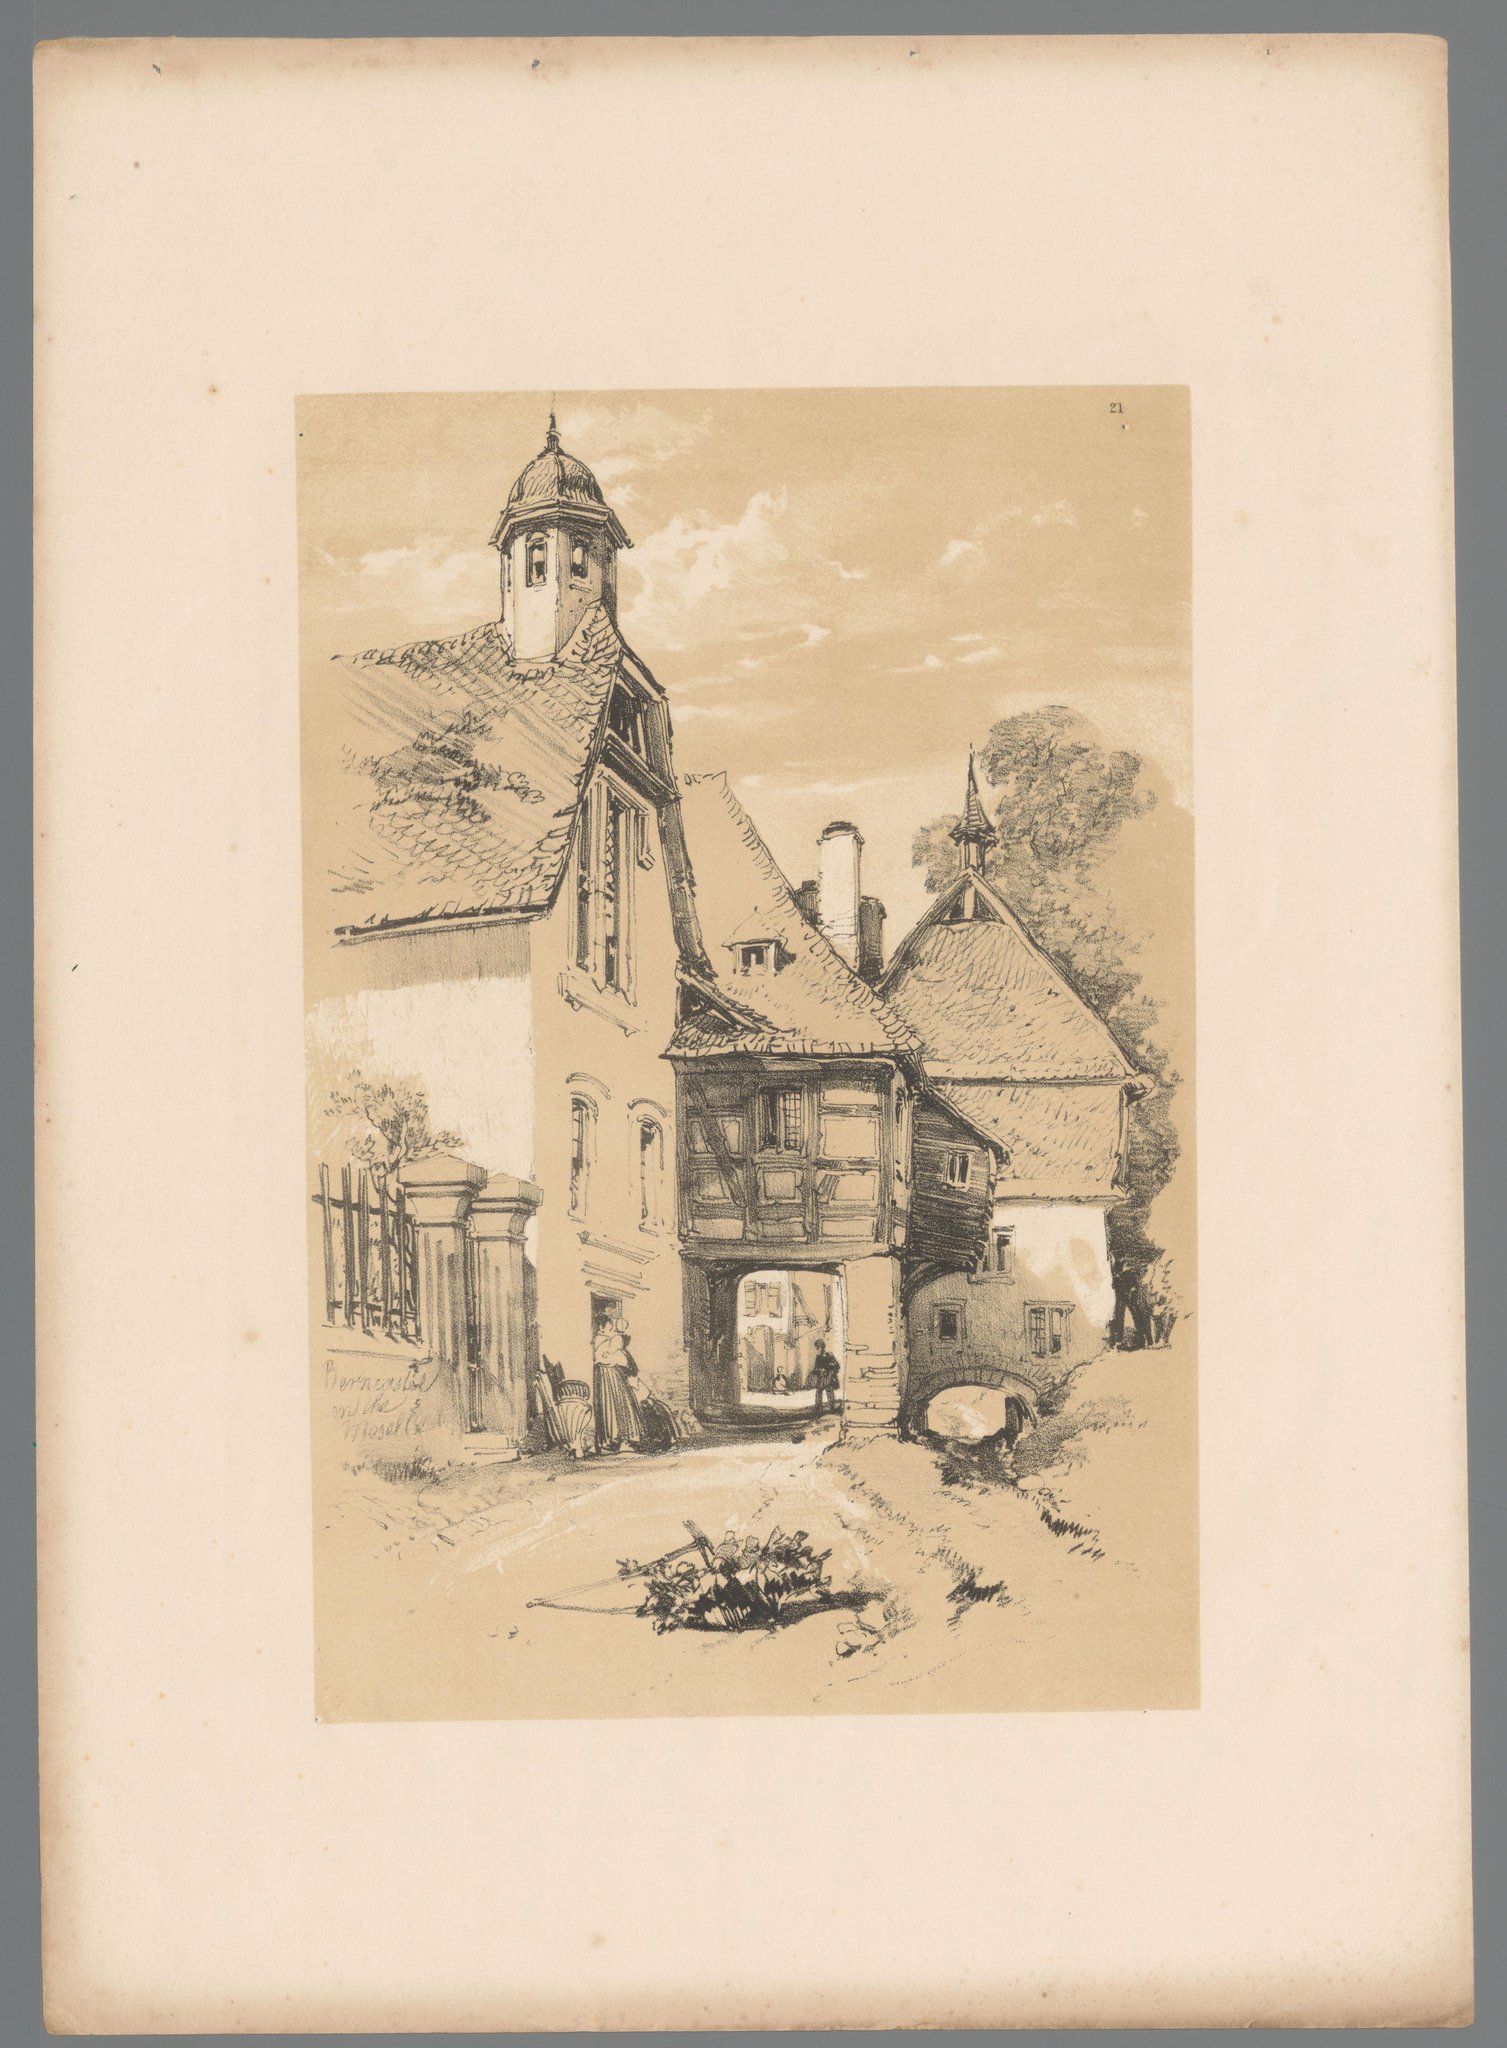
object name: print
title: Harding's drawing book for the year MDCCCXXXVIII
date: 1838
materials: paper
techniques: tone lithography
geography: london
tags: village (+ city(-scape) with figures, staffage)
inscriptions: collector's mark: Lugt 2228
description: Uitgever Charles Tilt heeft verschillende series uitgegeven over het werk van James Duffield Harding. Deze serie 'Harding's drawing book for the year MDCCCXXXVIII', bestaat uit zes delen met elk vier lithografieën.